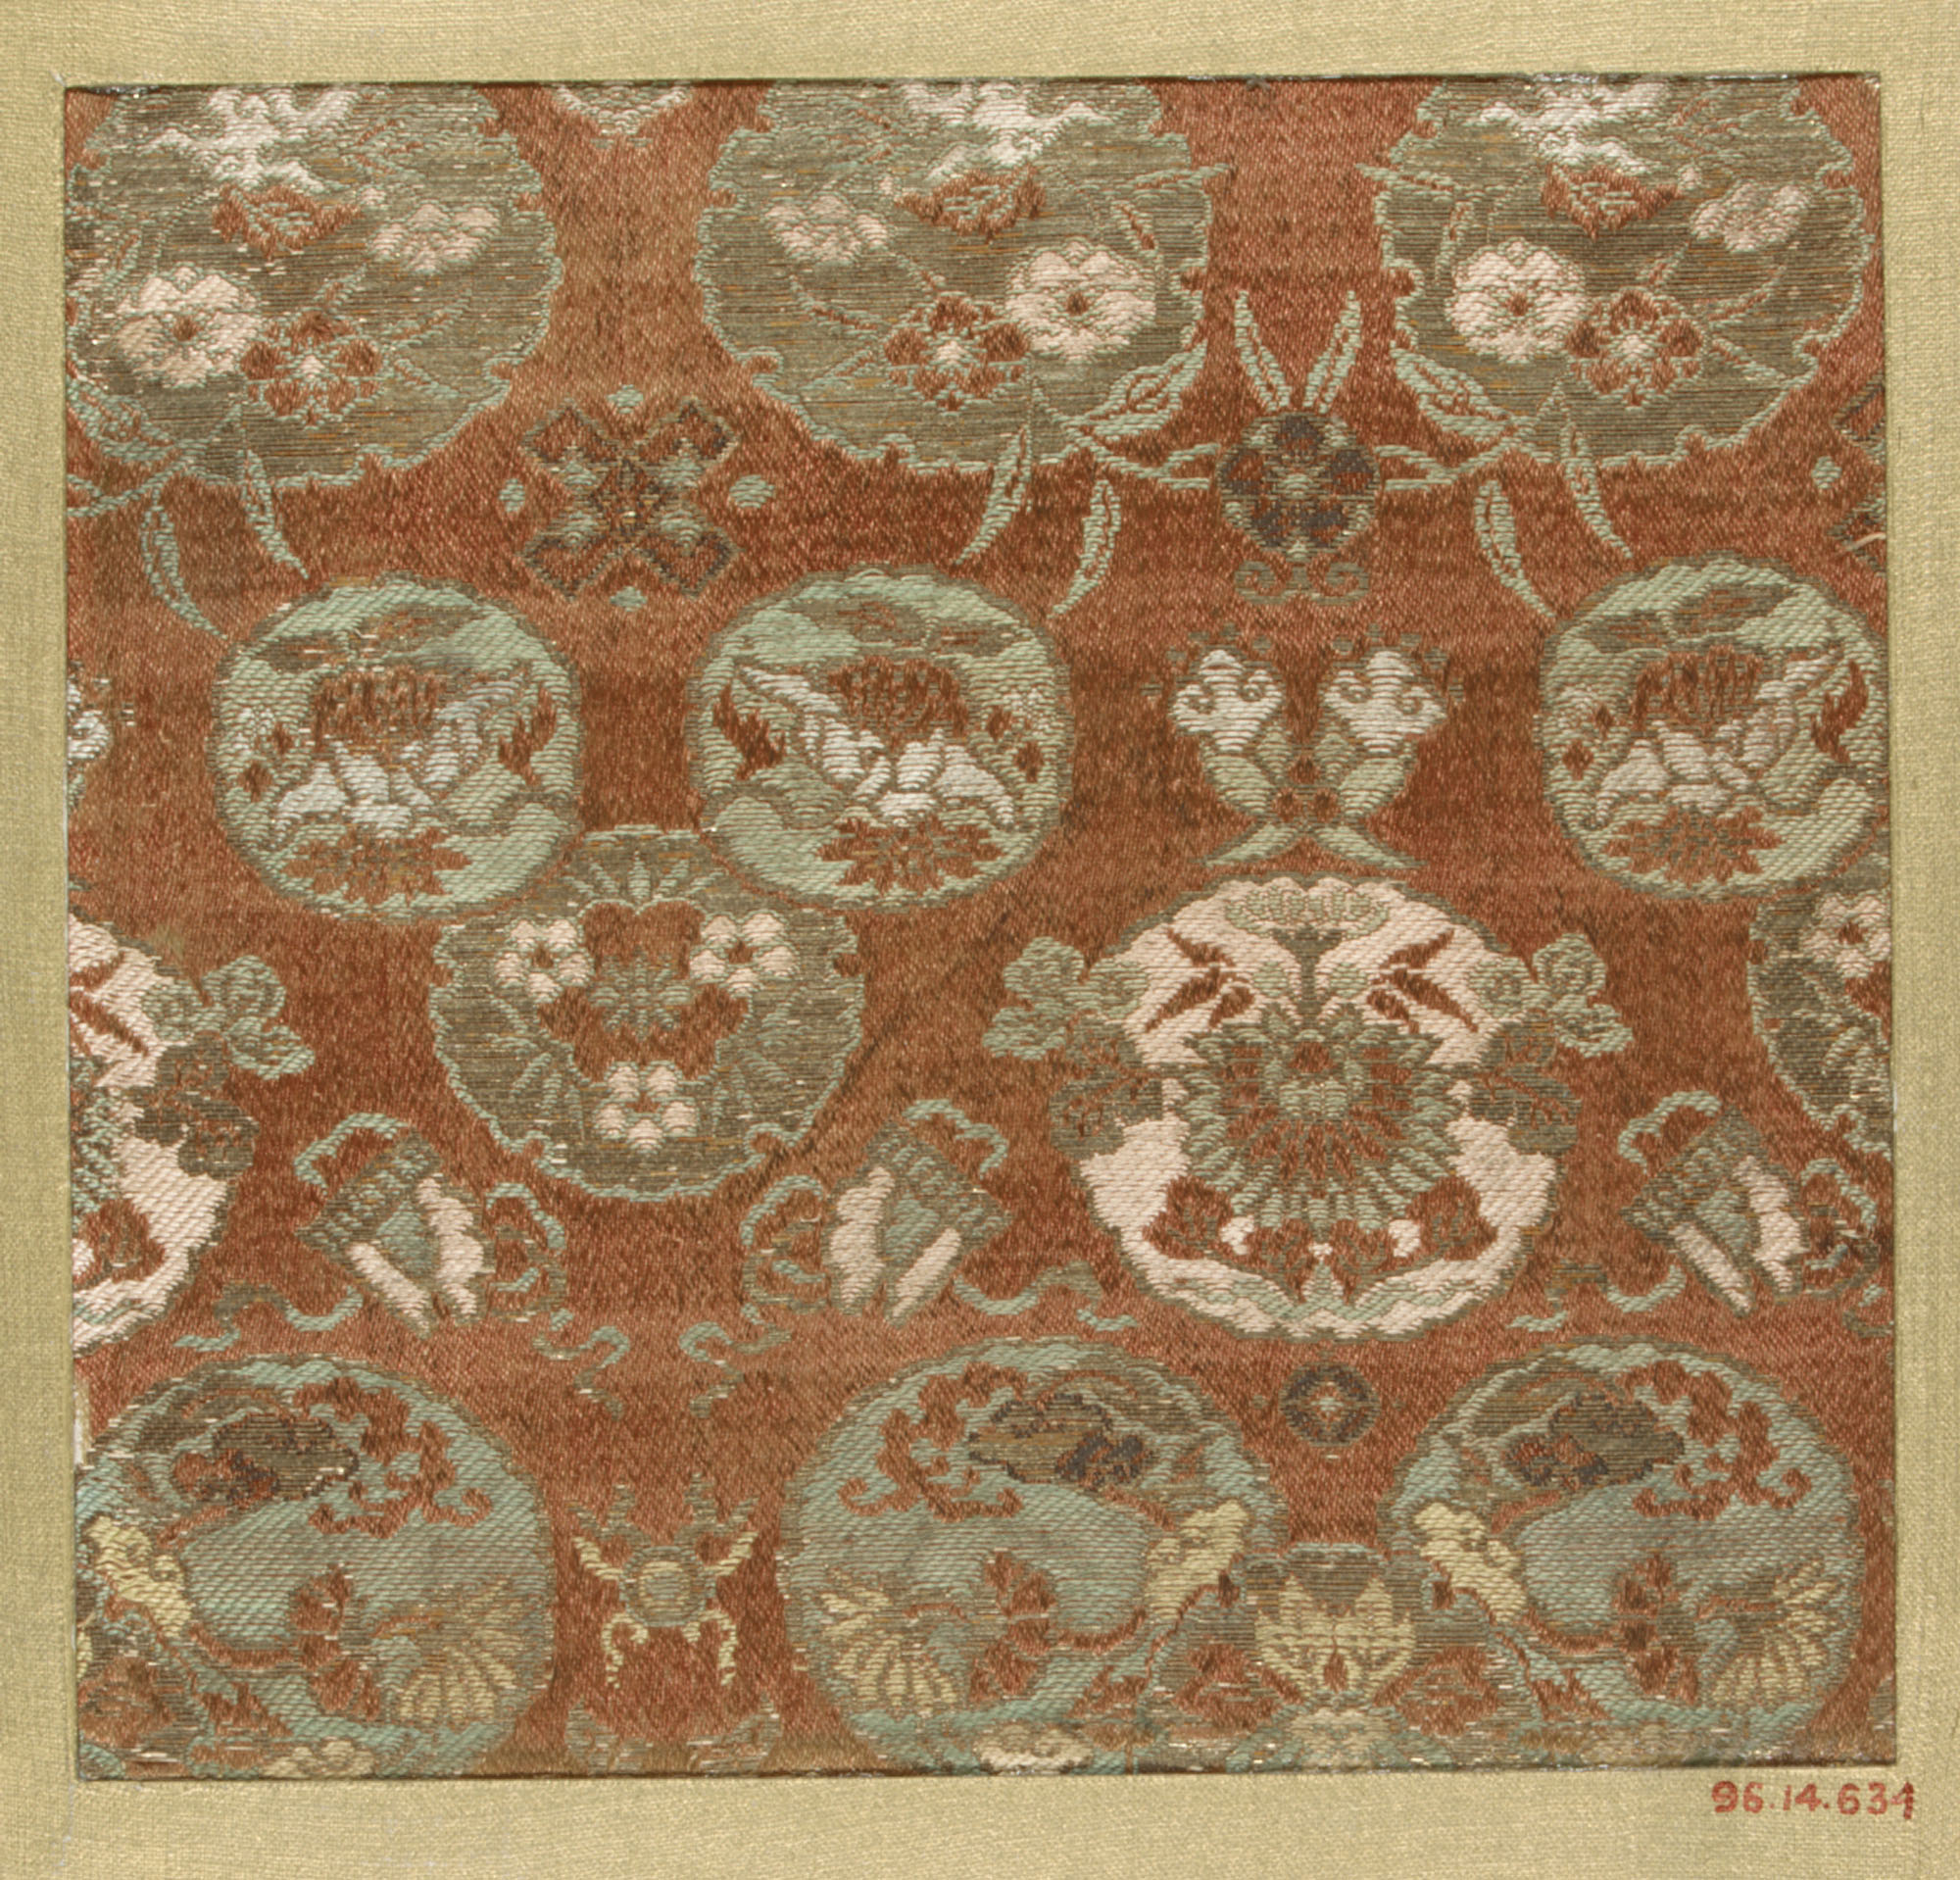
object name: piece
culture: japanese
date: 1701-1900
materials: silk